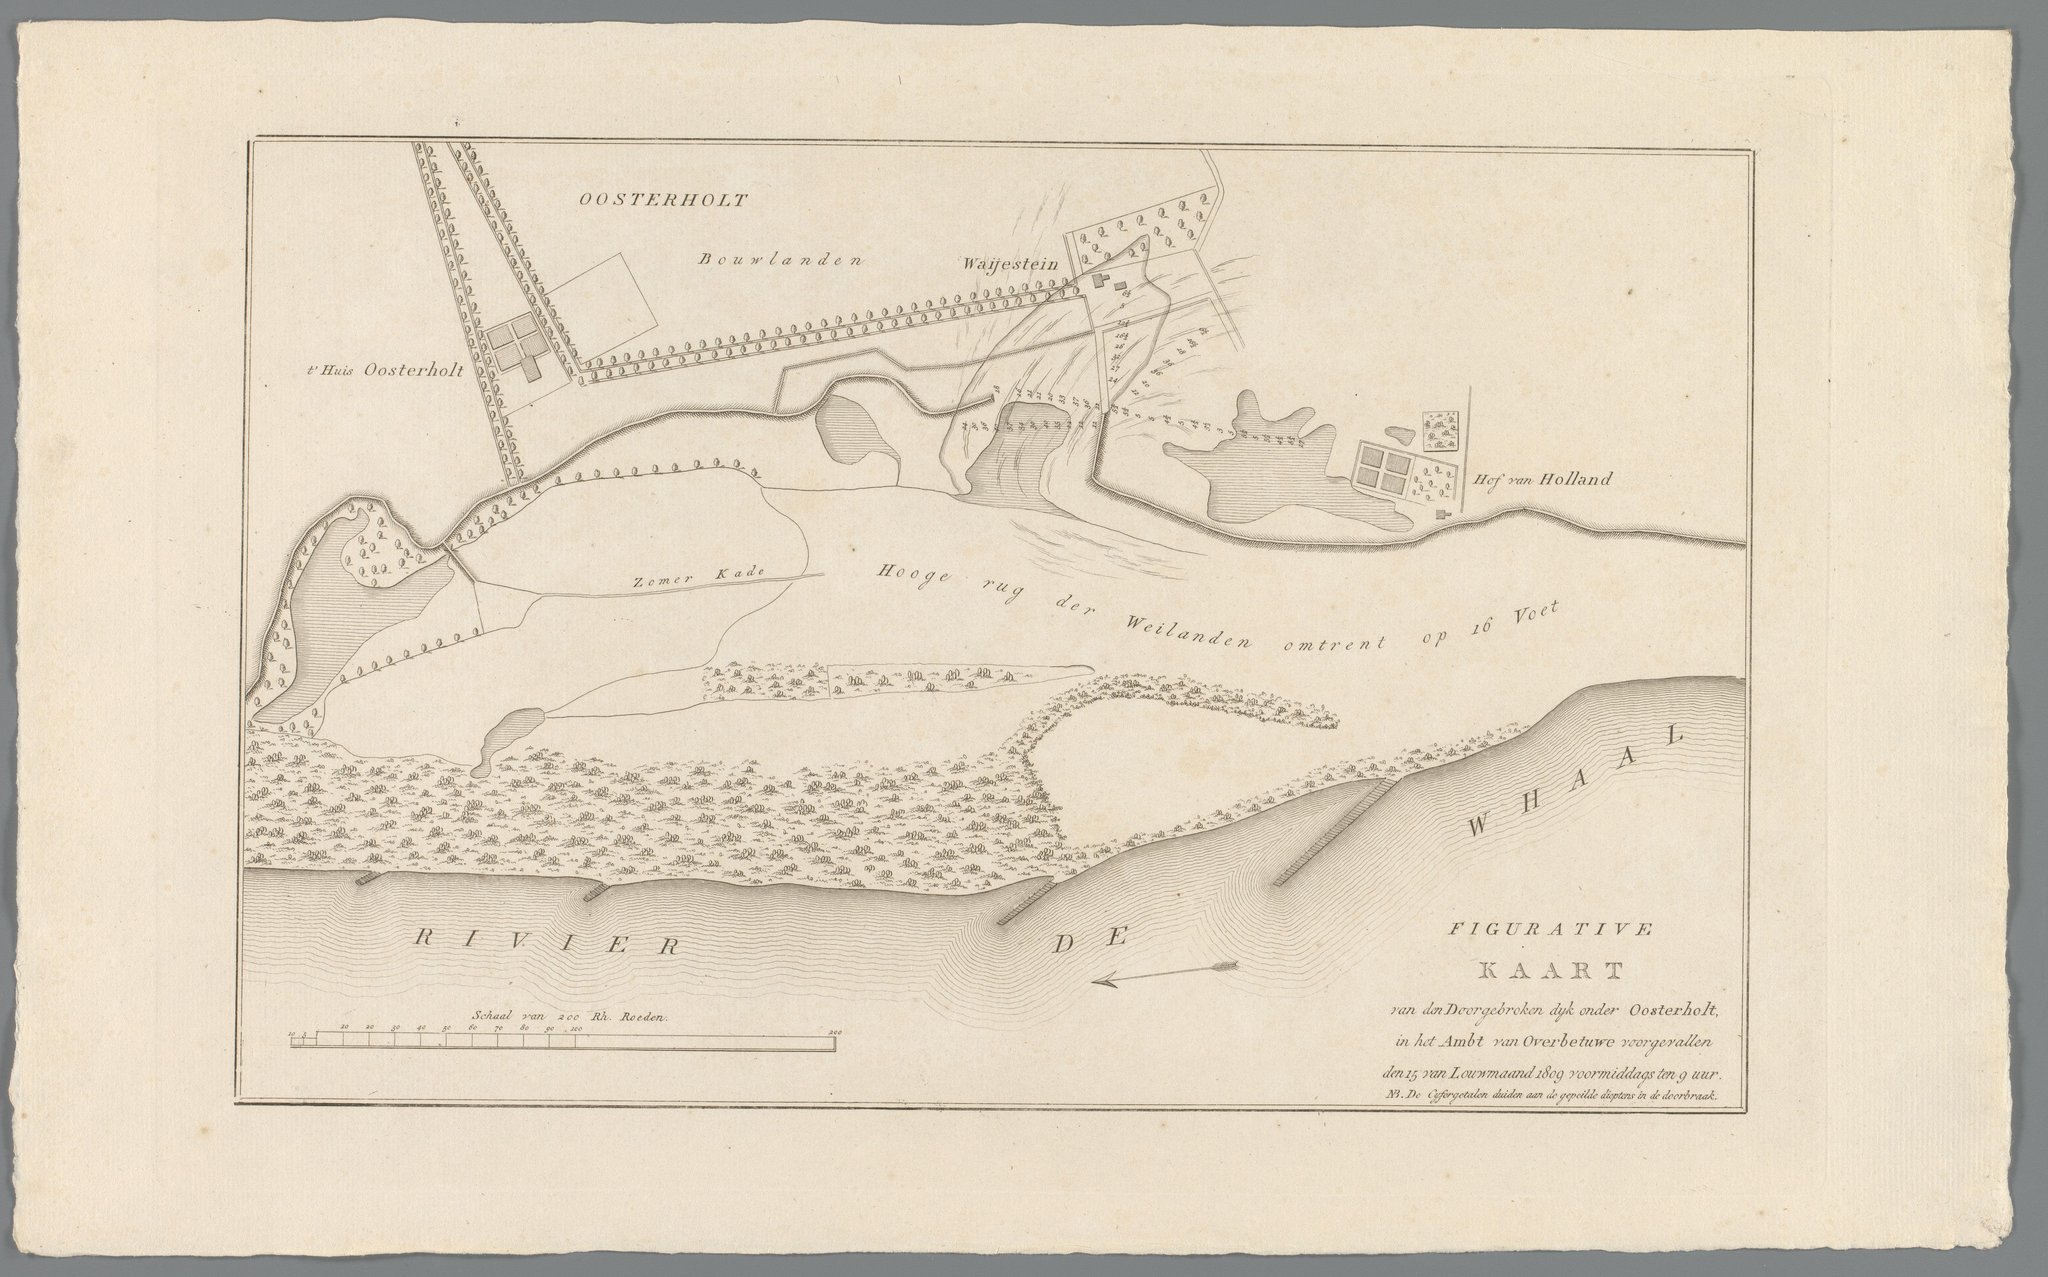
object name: map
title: Platen en kaarten behorende tot het geschiedkundig verslag der Dijkbreuken en Overstroomingen, in louwmaand MDCCCIX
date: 1809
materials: paper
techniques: engraving, etching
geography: amsterdam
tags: dike-break, maps of separate countries or regions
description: Prent ook gebruikt ter illustratie van: Hendrik Ewijk. Geschiedkundig verslag der dijkbreuken en overstroomingen, langs de rivieren in het Koningrijk Holland, voorgevallen in louwmaand MDCCCIX. 3 dln. Amsterdam: Johannes Allart en Jacobus Ruys, 1809.